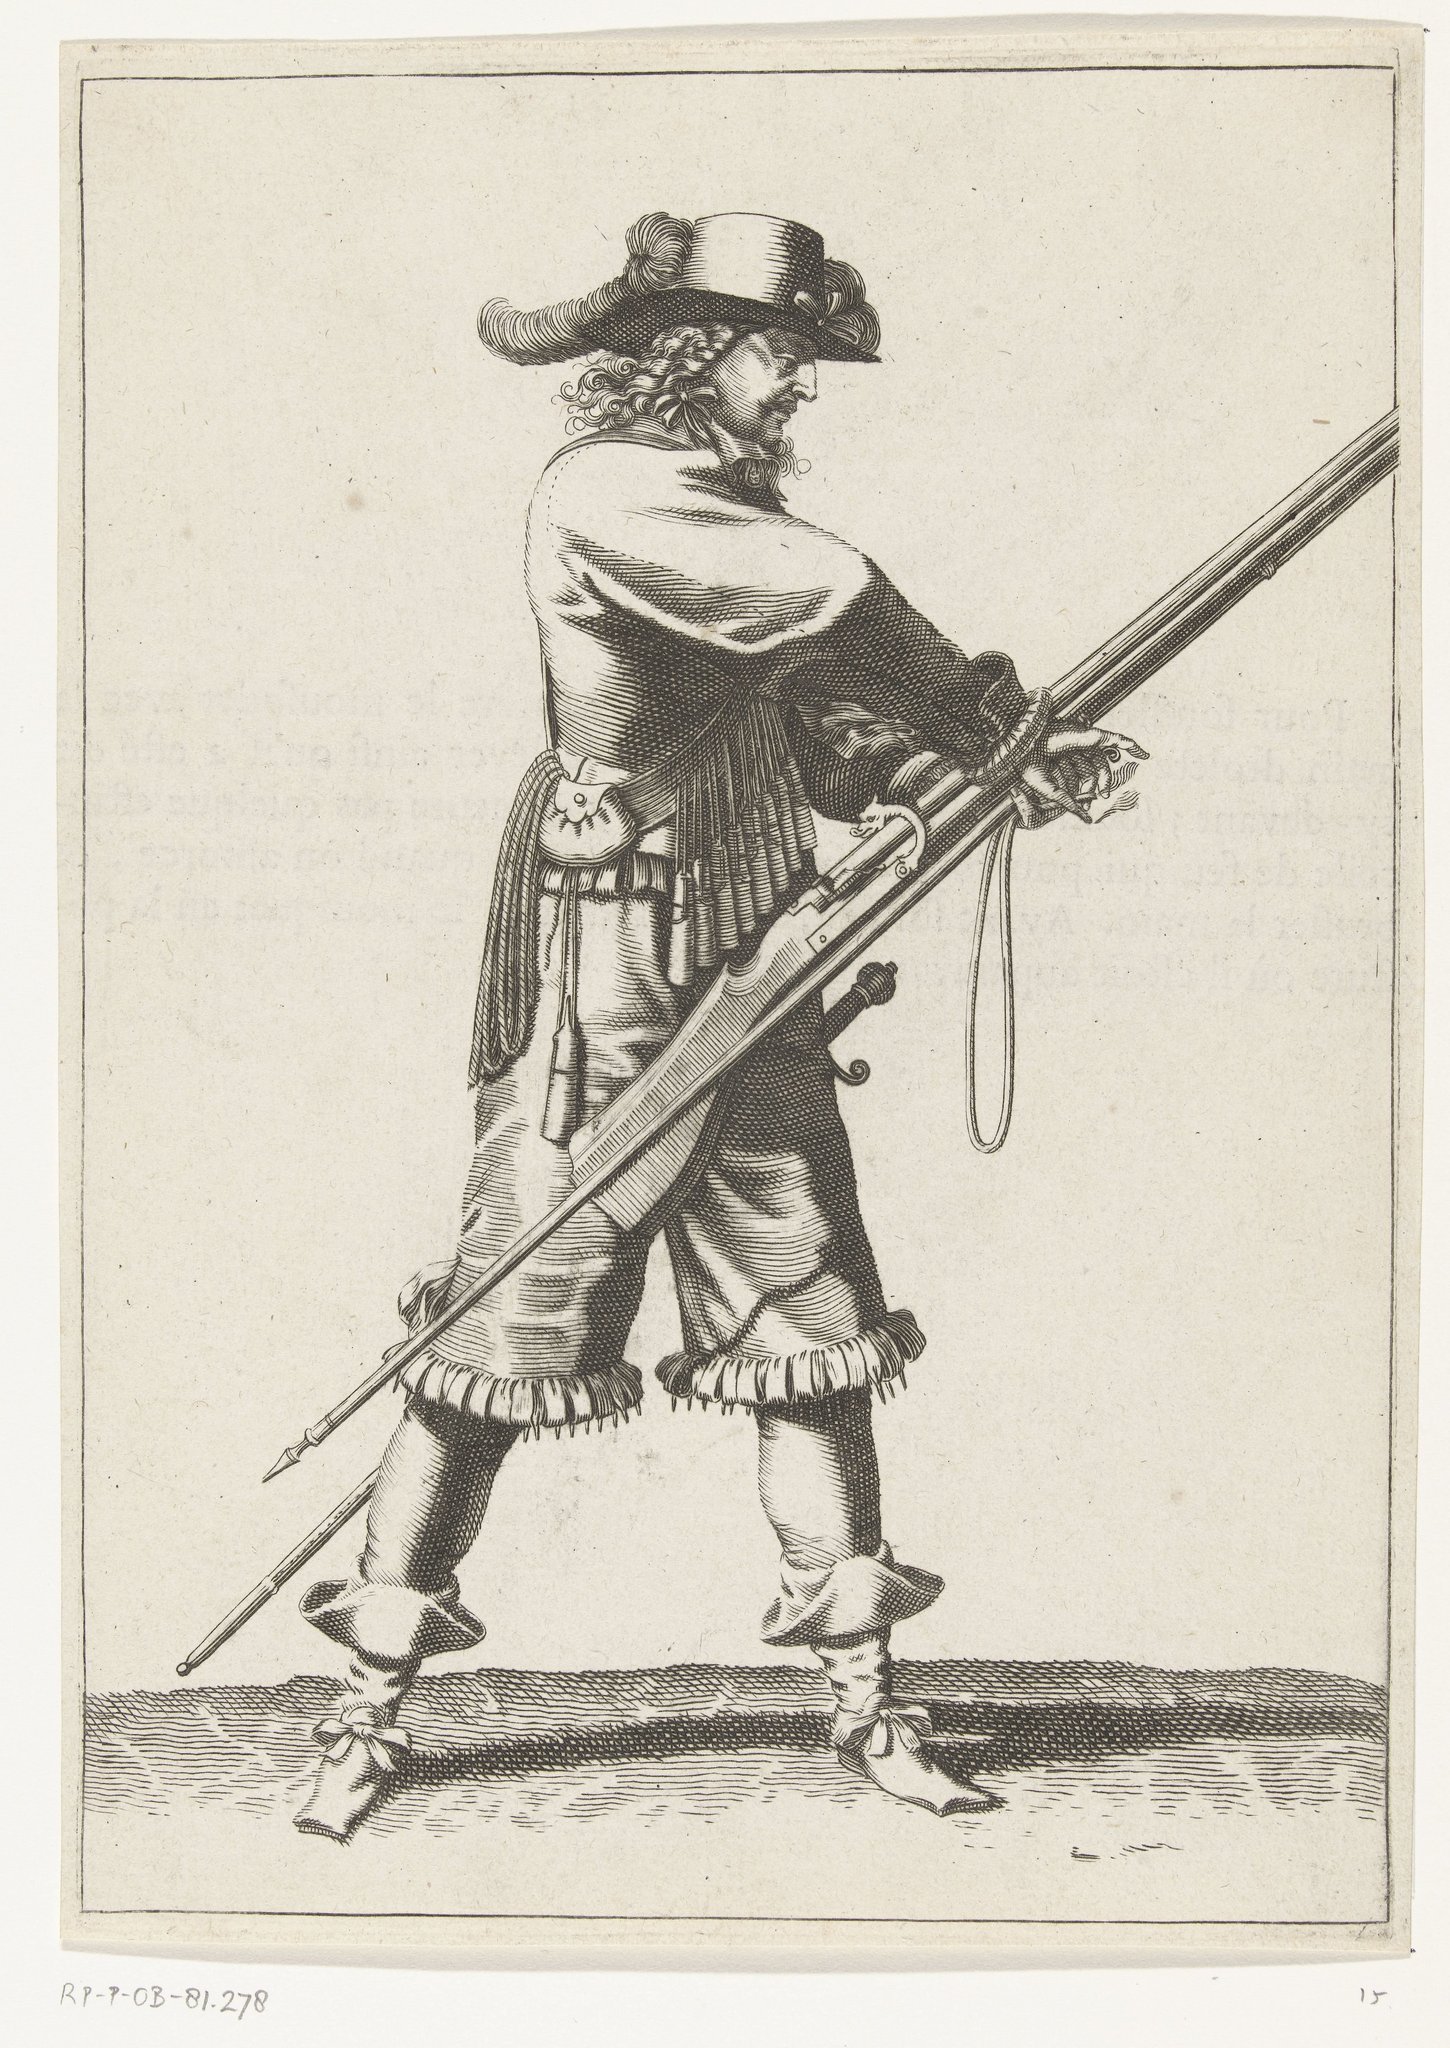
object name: print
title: Soldaat met een musket die zijn lont overbrengt van zijn rechter- naar zijn linkerhand, ca. 1645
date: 1645-1647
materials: paper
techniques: engraving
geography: southern netherlands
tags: handling of weapons ~ military training, weapons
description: Een soldaat, ten voeten uit, naar rechts, die een musket (een bepaald type vuurwapen) en een furket (musketvork) met zijn linkerhand vasthoudt. De brandende lont in zijn rechterhand brengt hij over naar zijn linkerhand, ca. 1645. Bedrukt op achterzijde met tekst in het Frans. Vrij naar plaat 15 in de instructies voor het hanteren van het musket in de Wapenhandelinghe van J. de Gheyn. Krijgswezen rond 1600.